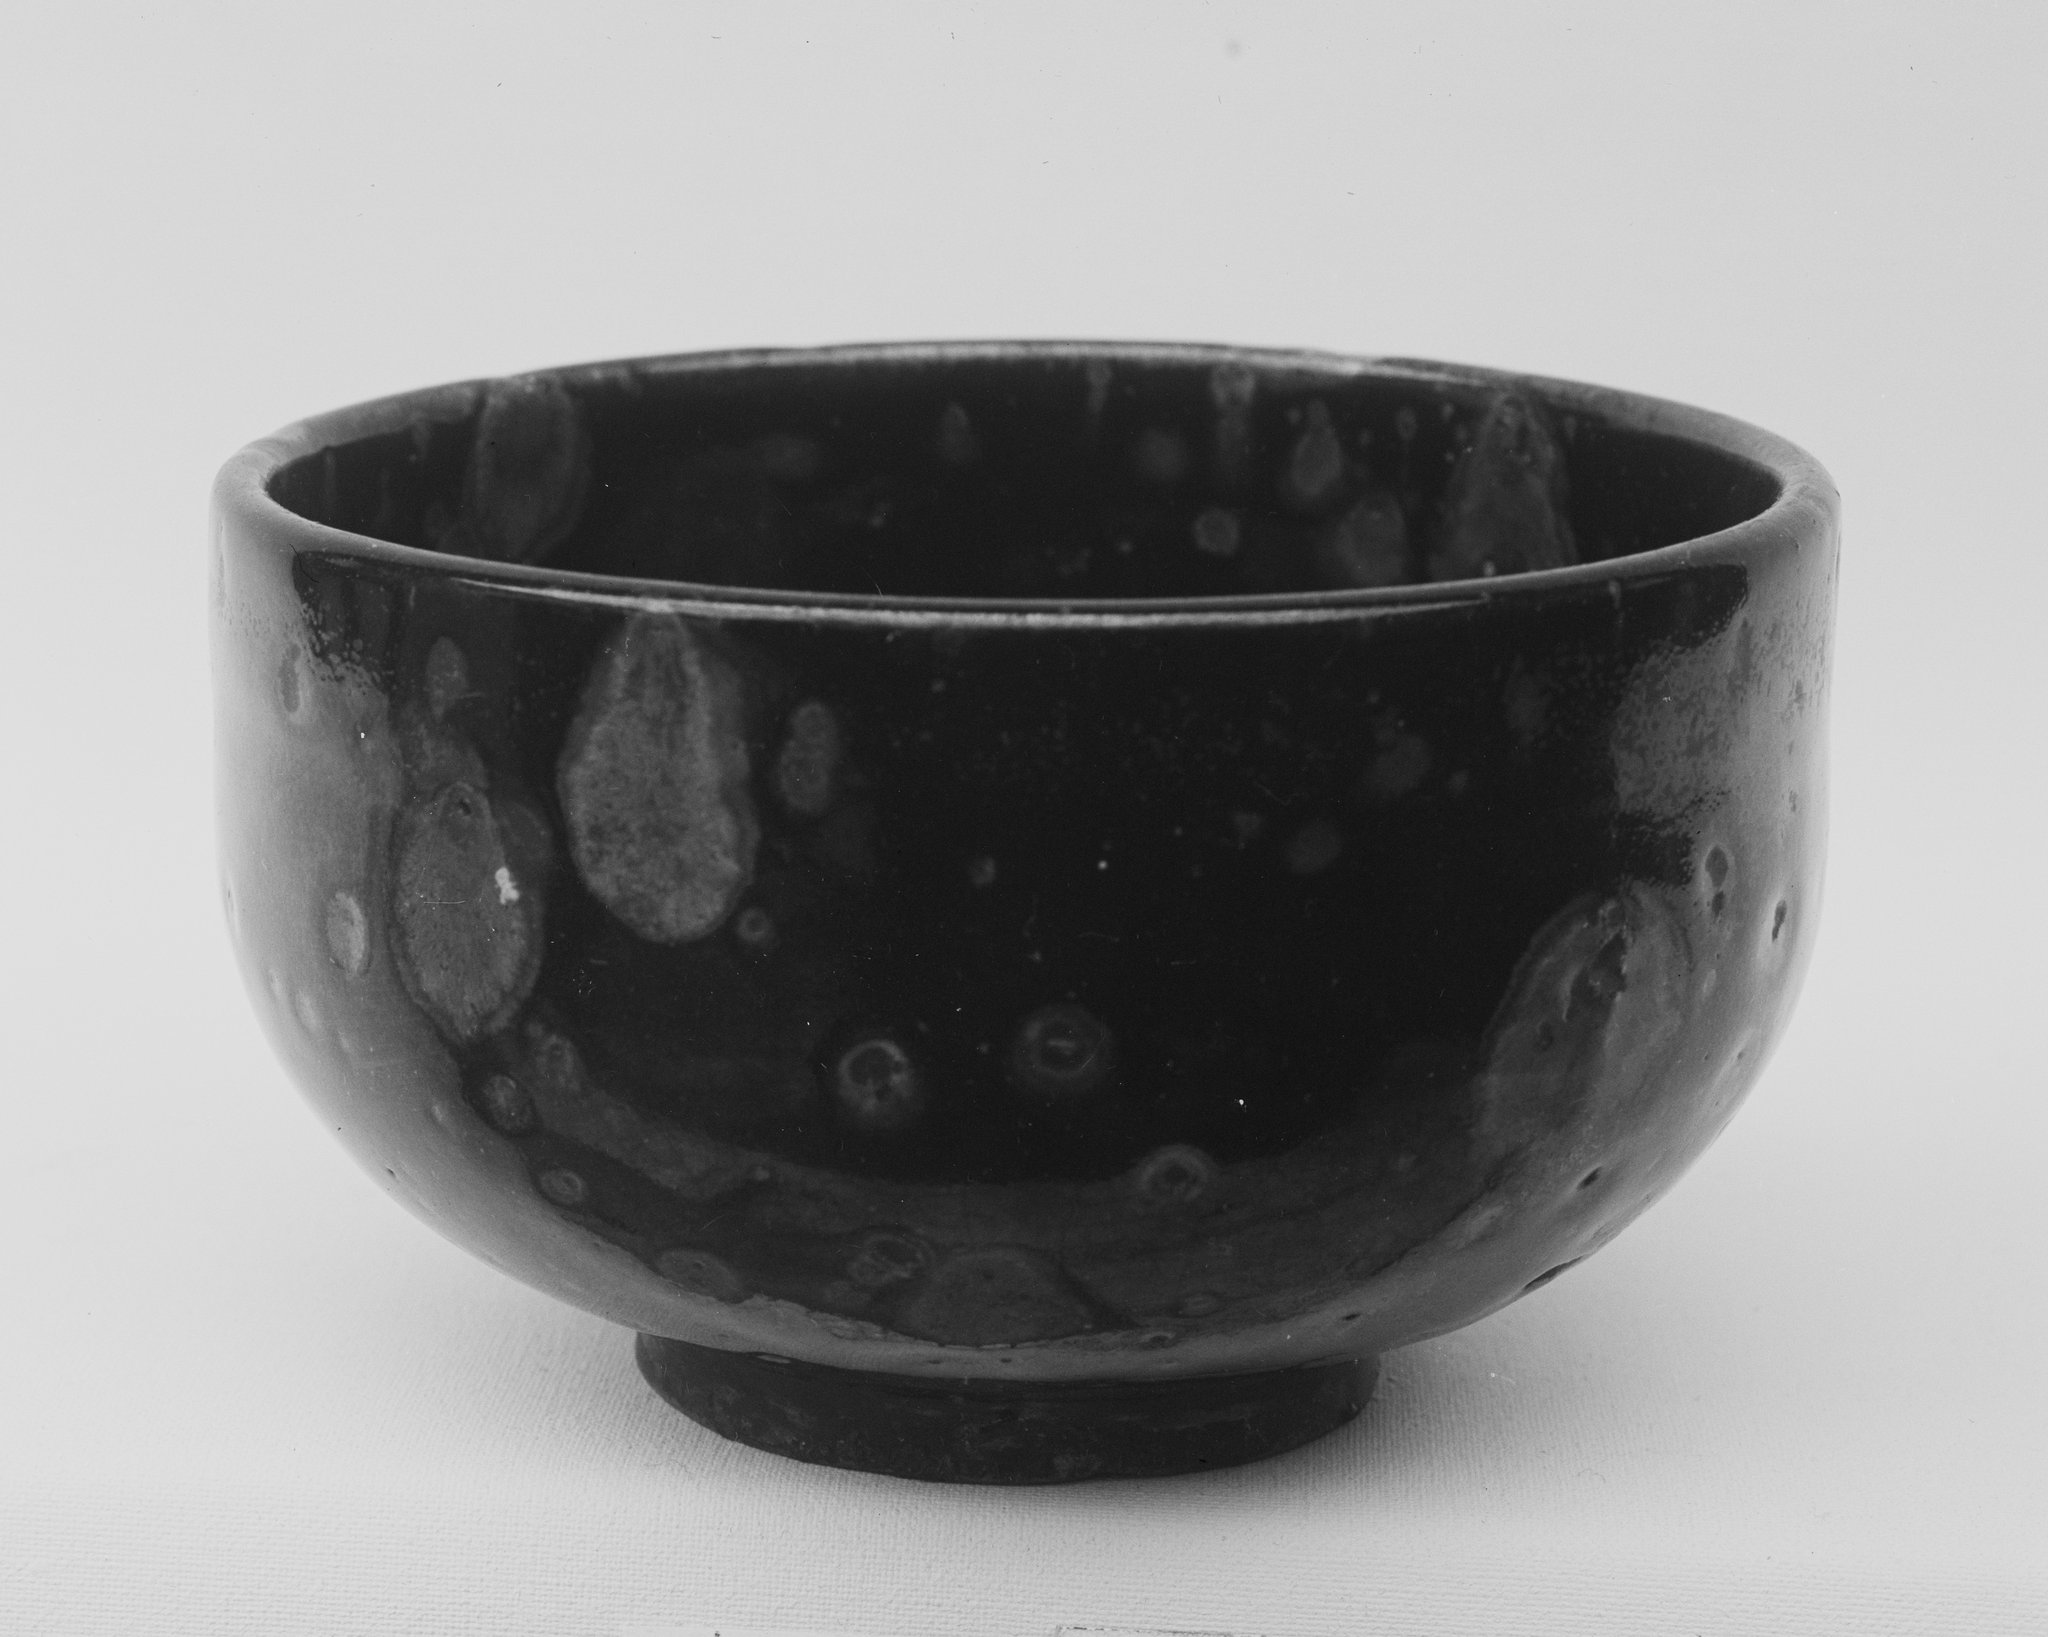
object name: bowl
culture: japanese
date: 1700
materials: clay, glaze